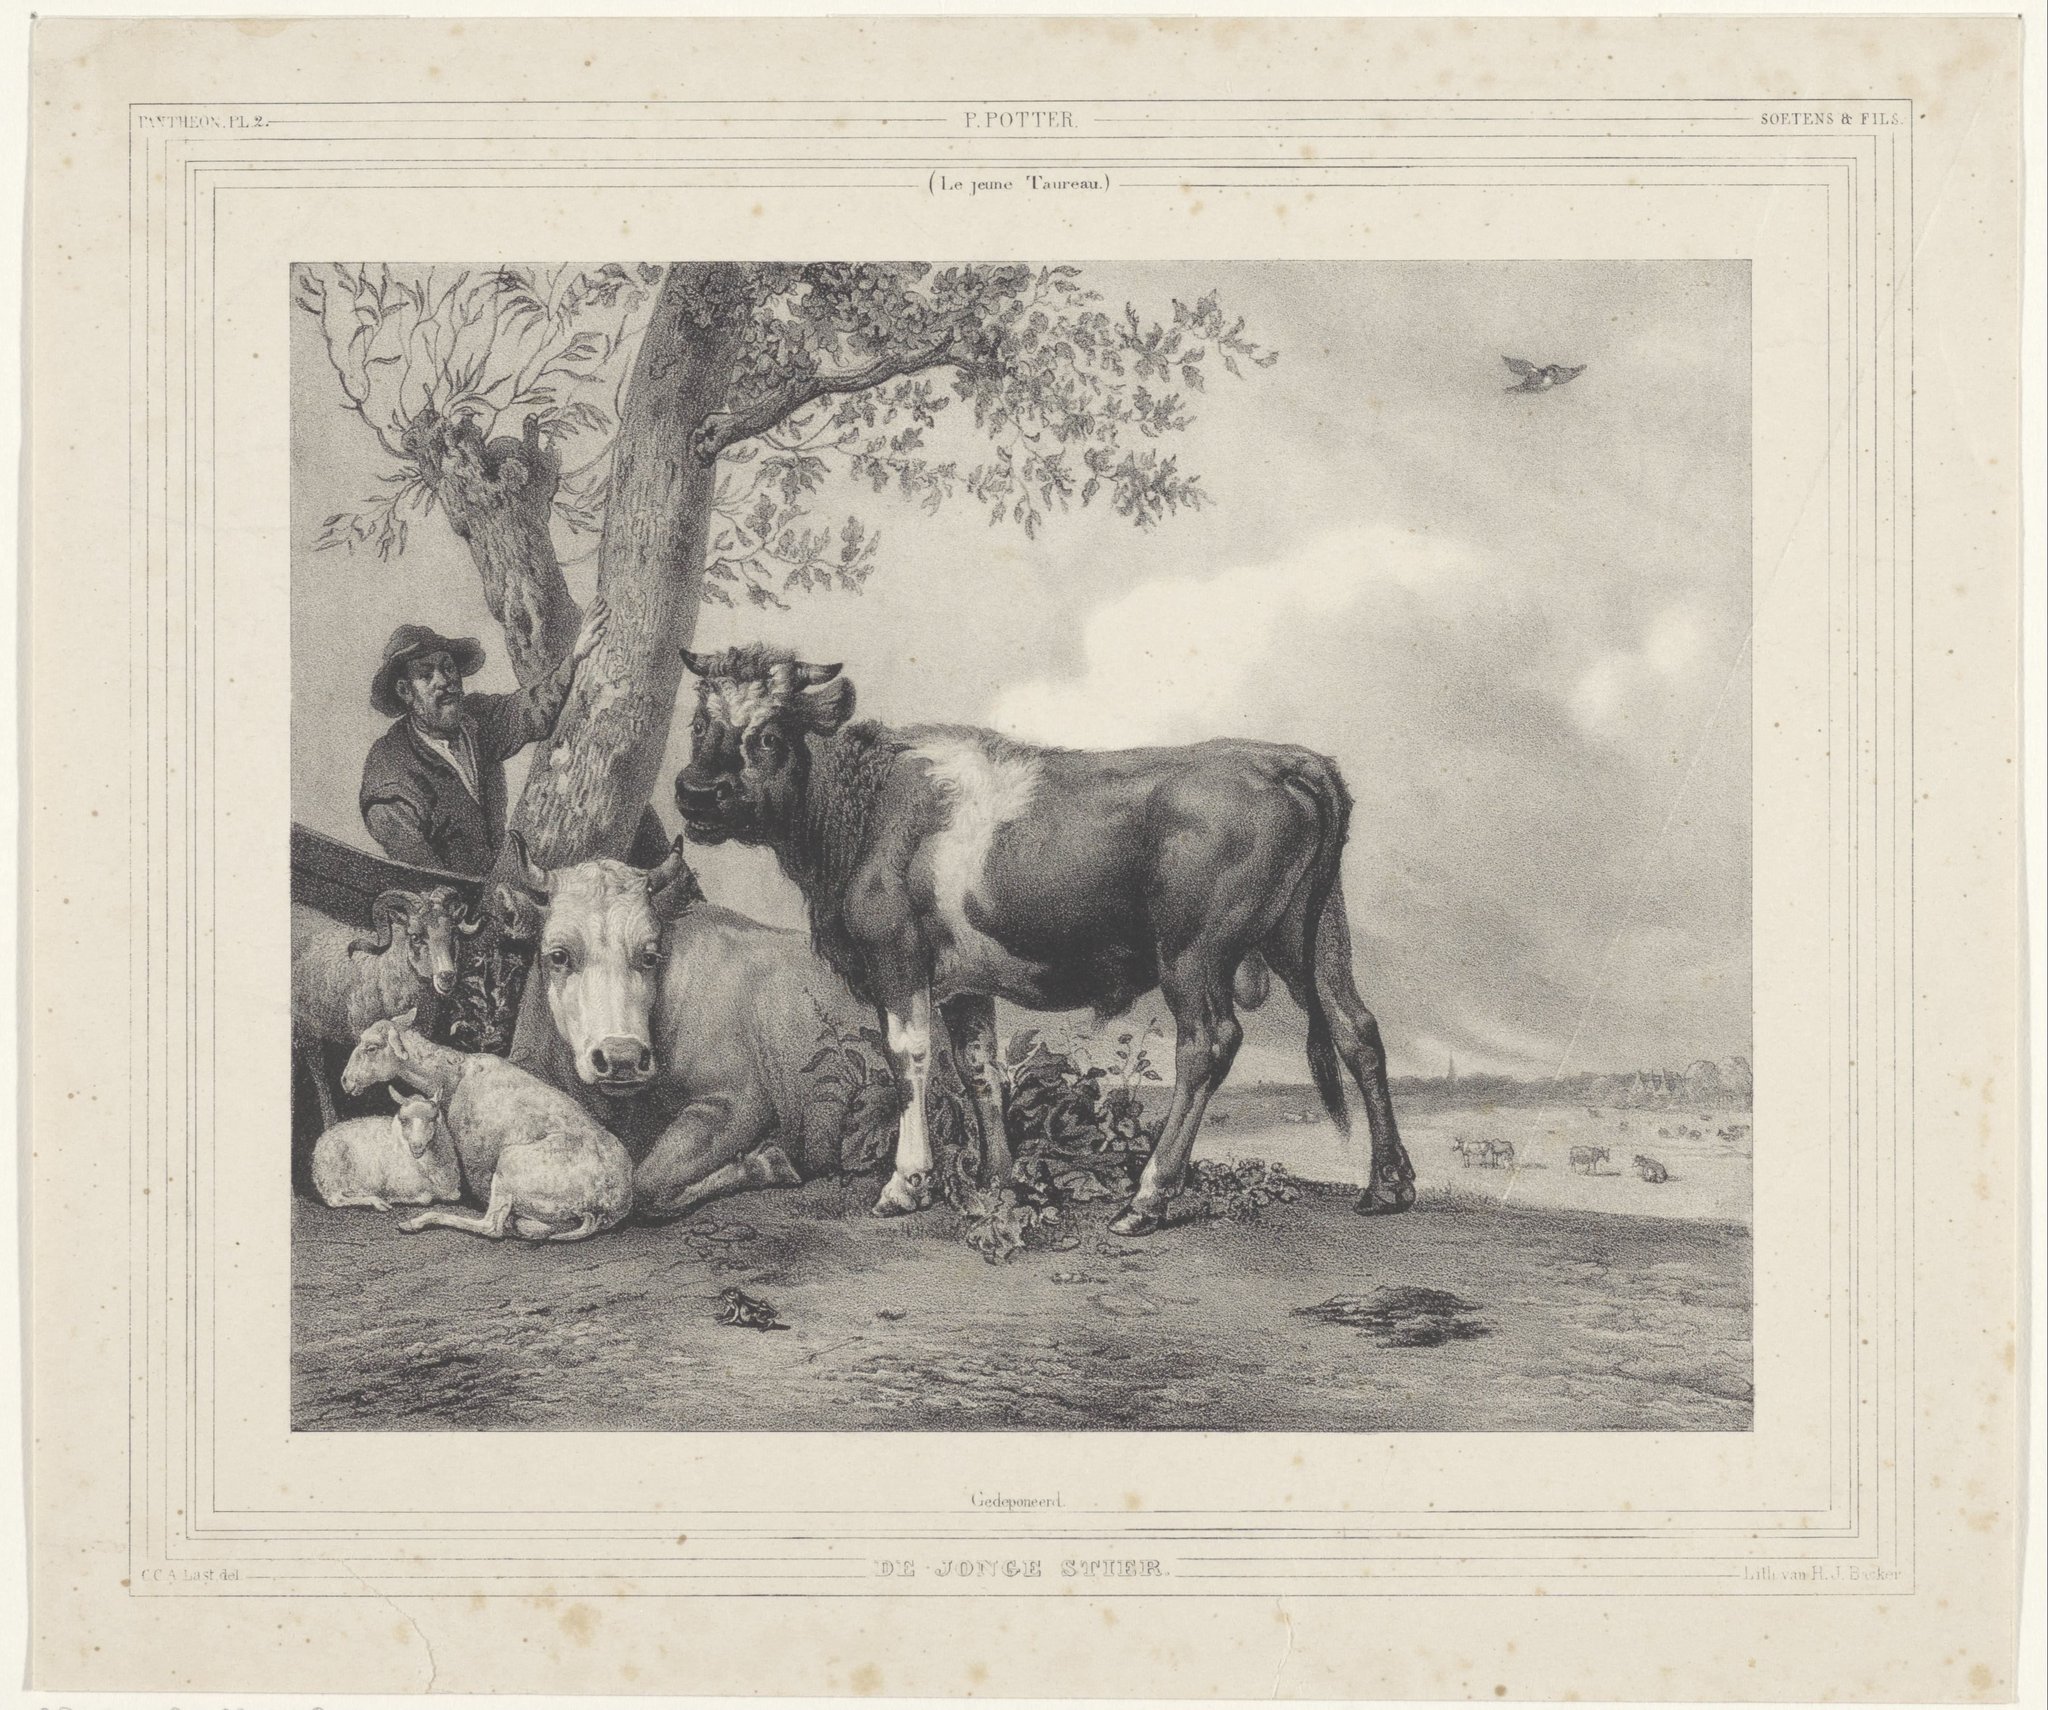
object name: print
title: De jonge stier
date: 1837-1840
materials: paper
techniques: lithograph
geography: netherlands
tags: bull, cow, goat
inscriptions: collector's mark: Lugt 2228, : ‘Gedeponeerd.’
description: In een landschap bij twee bomen staat een stier en ligt een koe. Daarnaast een schaap, een lam en een bok. Achter de bomen een man. Verderop een weiland met koeien. Op de voorgrond een kikker en in de lucht een vogel.